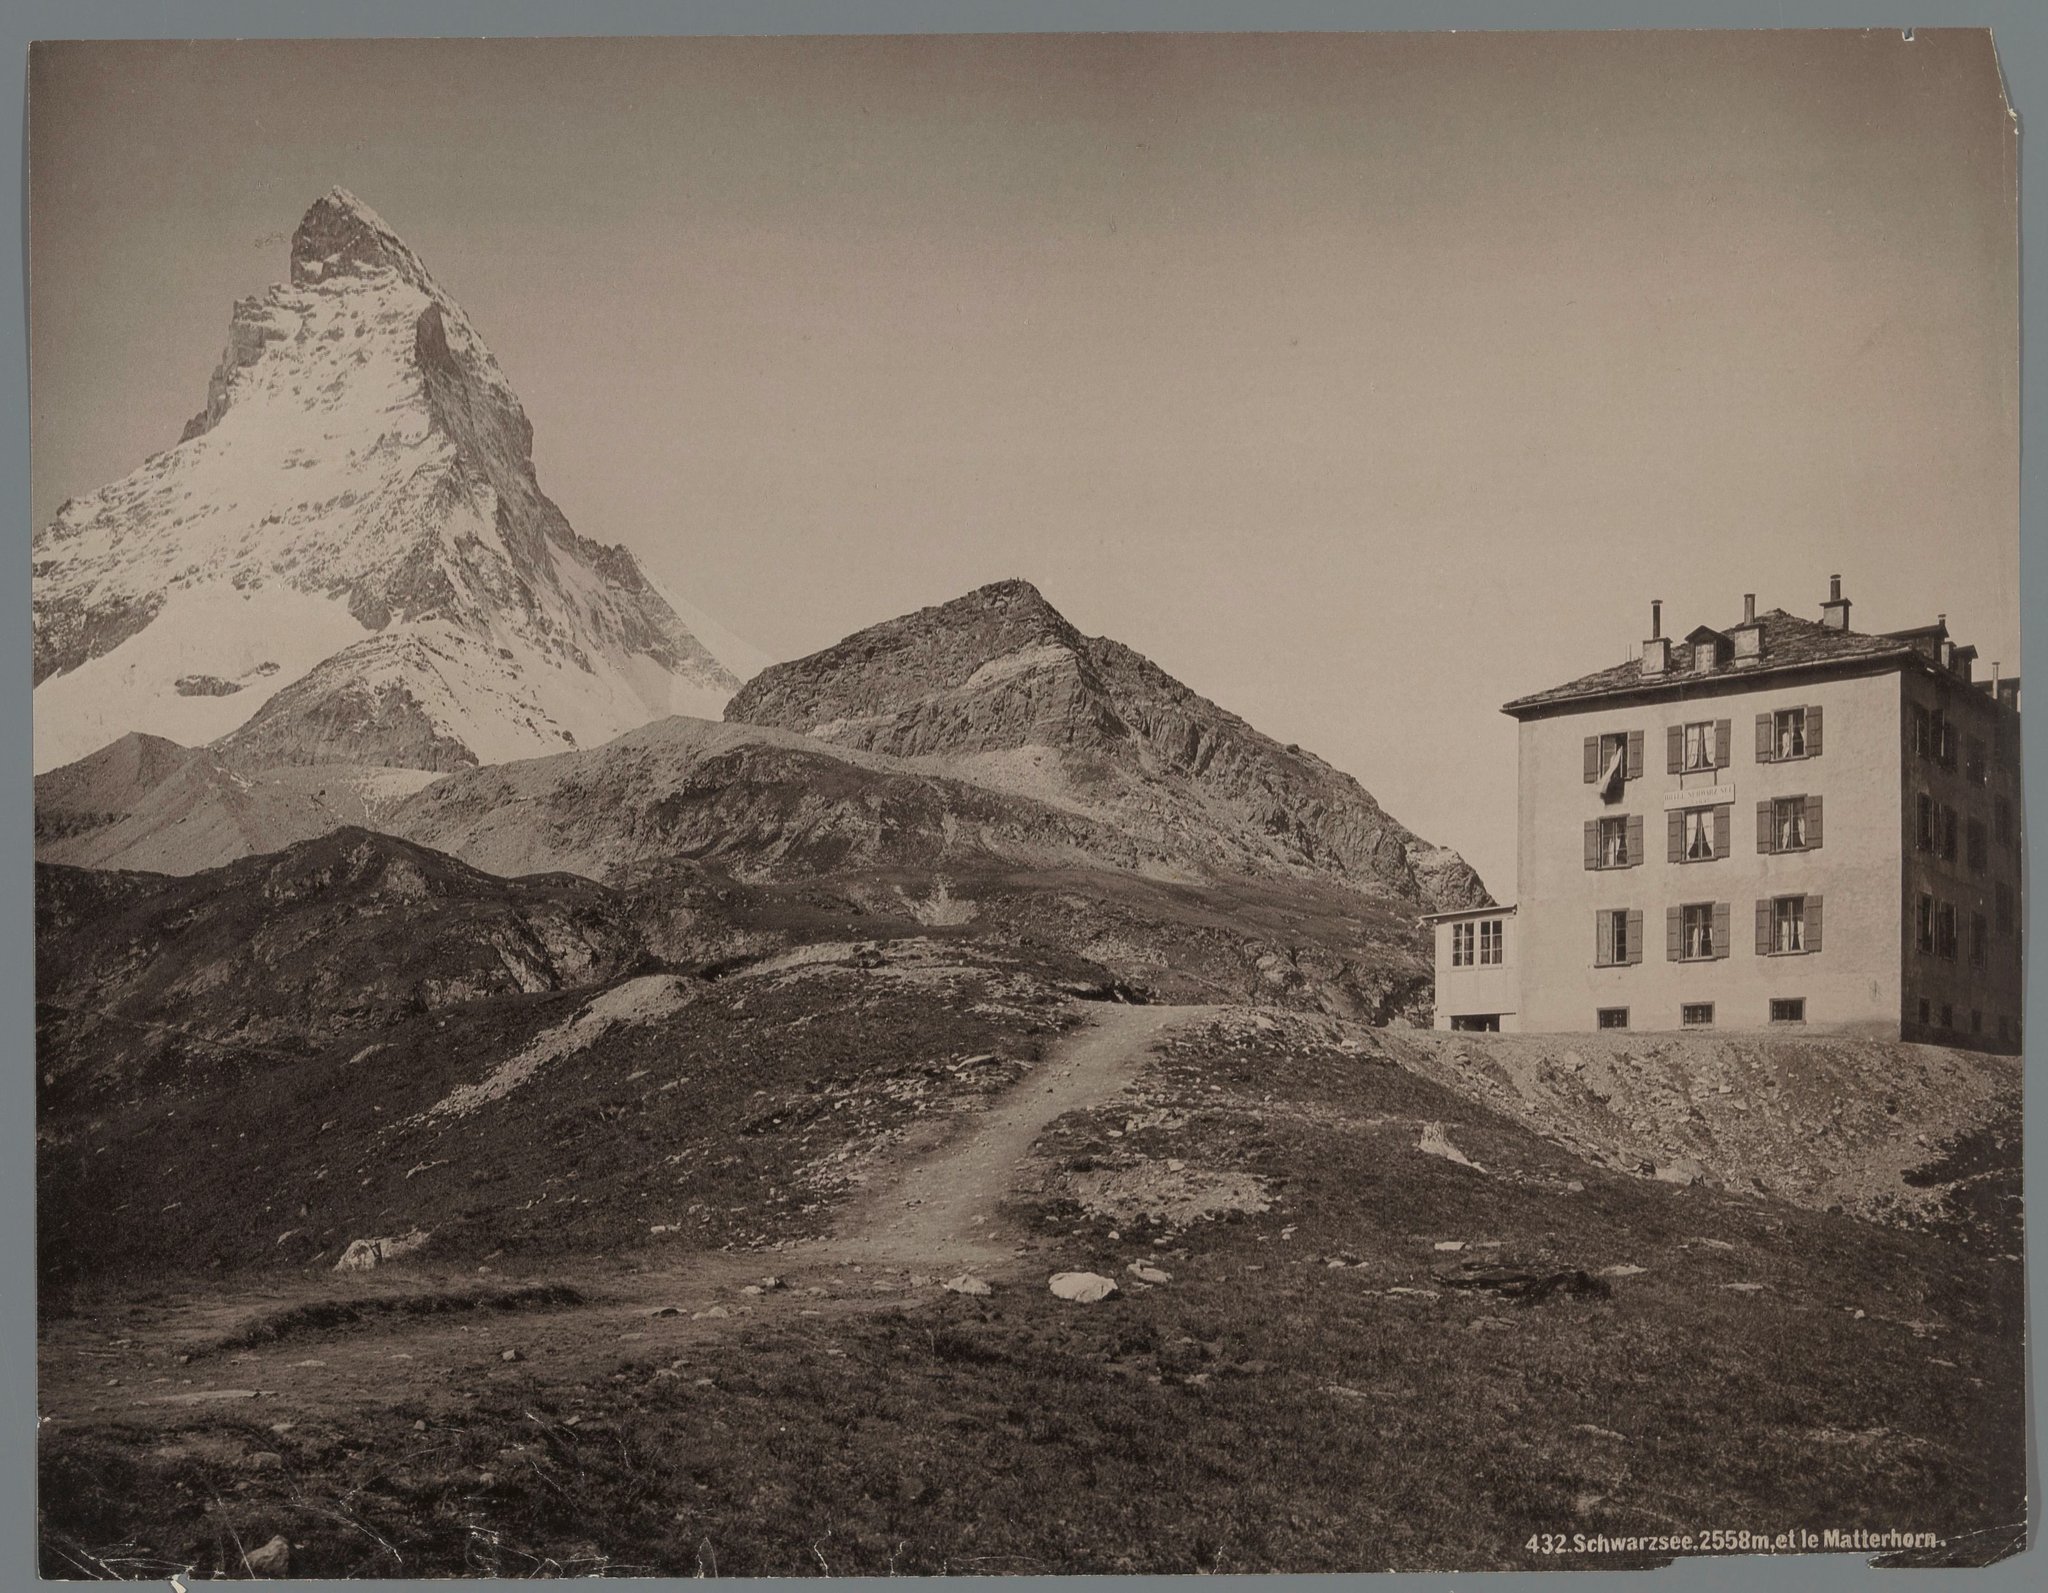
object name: photomechanical print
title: Hotel Schwarzsee in Zermatt aan de voet van de Matterhorn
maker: Anonymous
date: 1870-1930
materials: paper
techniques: photograph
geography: zurich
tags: mountain-top, peak, hotel, hostelry, inn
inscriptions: number: ‘432.’